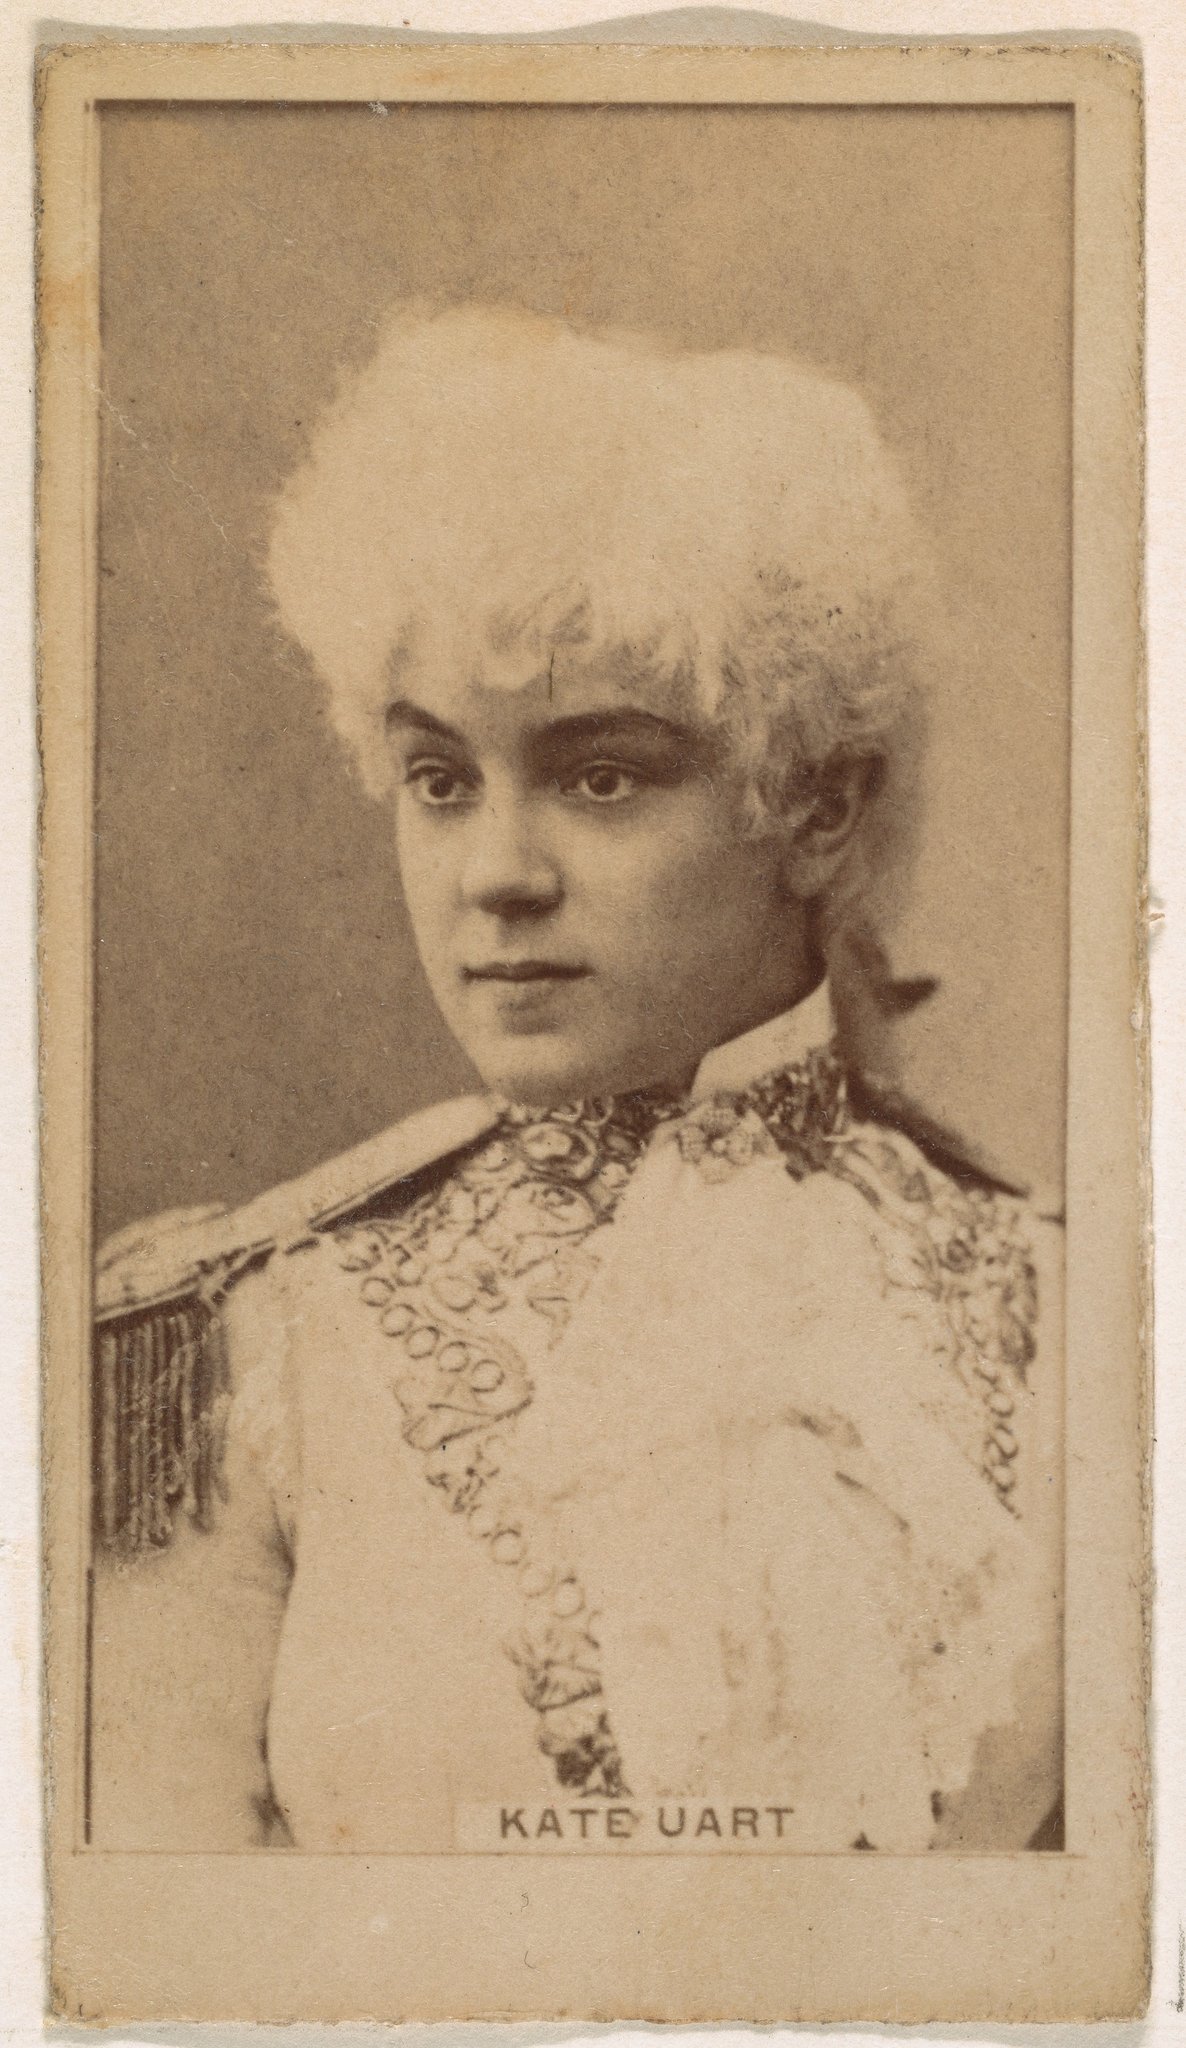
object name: photograph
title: Kate Uart, from the Actresses series (N245) issued by Kinney Brothers to promote Sweet Caporal Cigarettes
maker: kinney brothers tobacco company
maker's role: publisher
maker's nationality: american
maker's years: 1869-2011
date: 1890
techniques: albumen silver print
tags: portraits,women,actresses